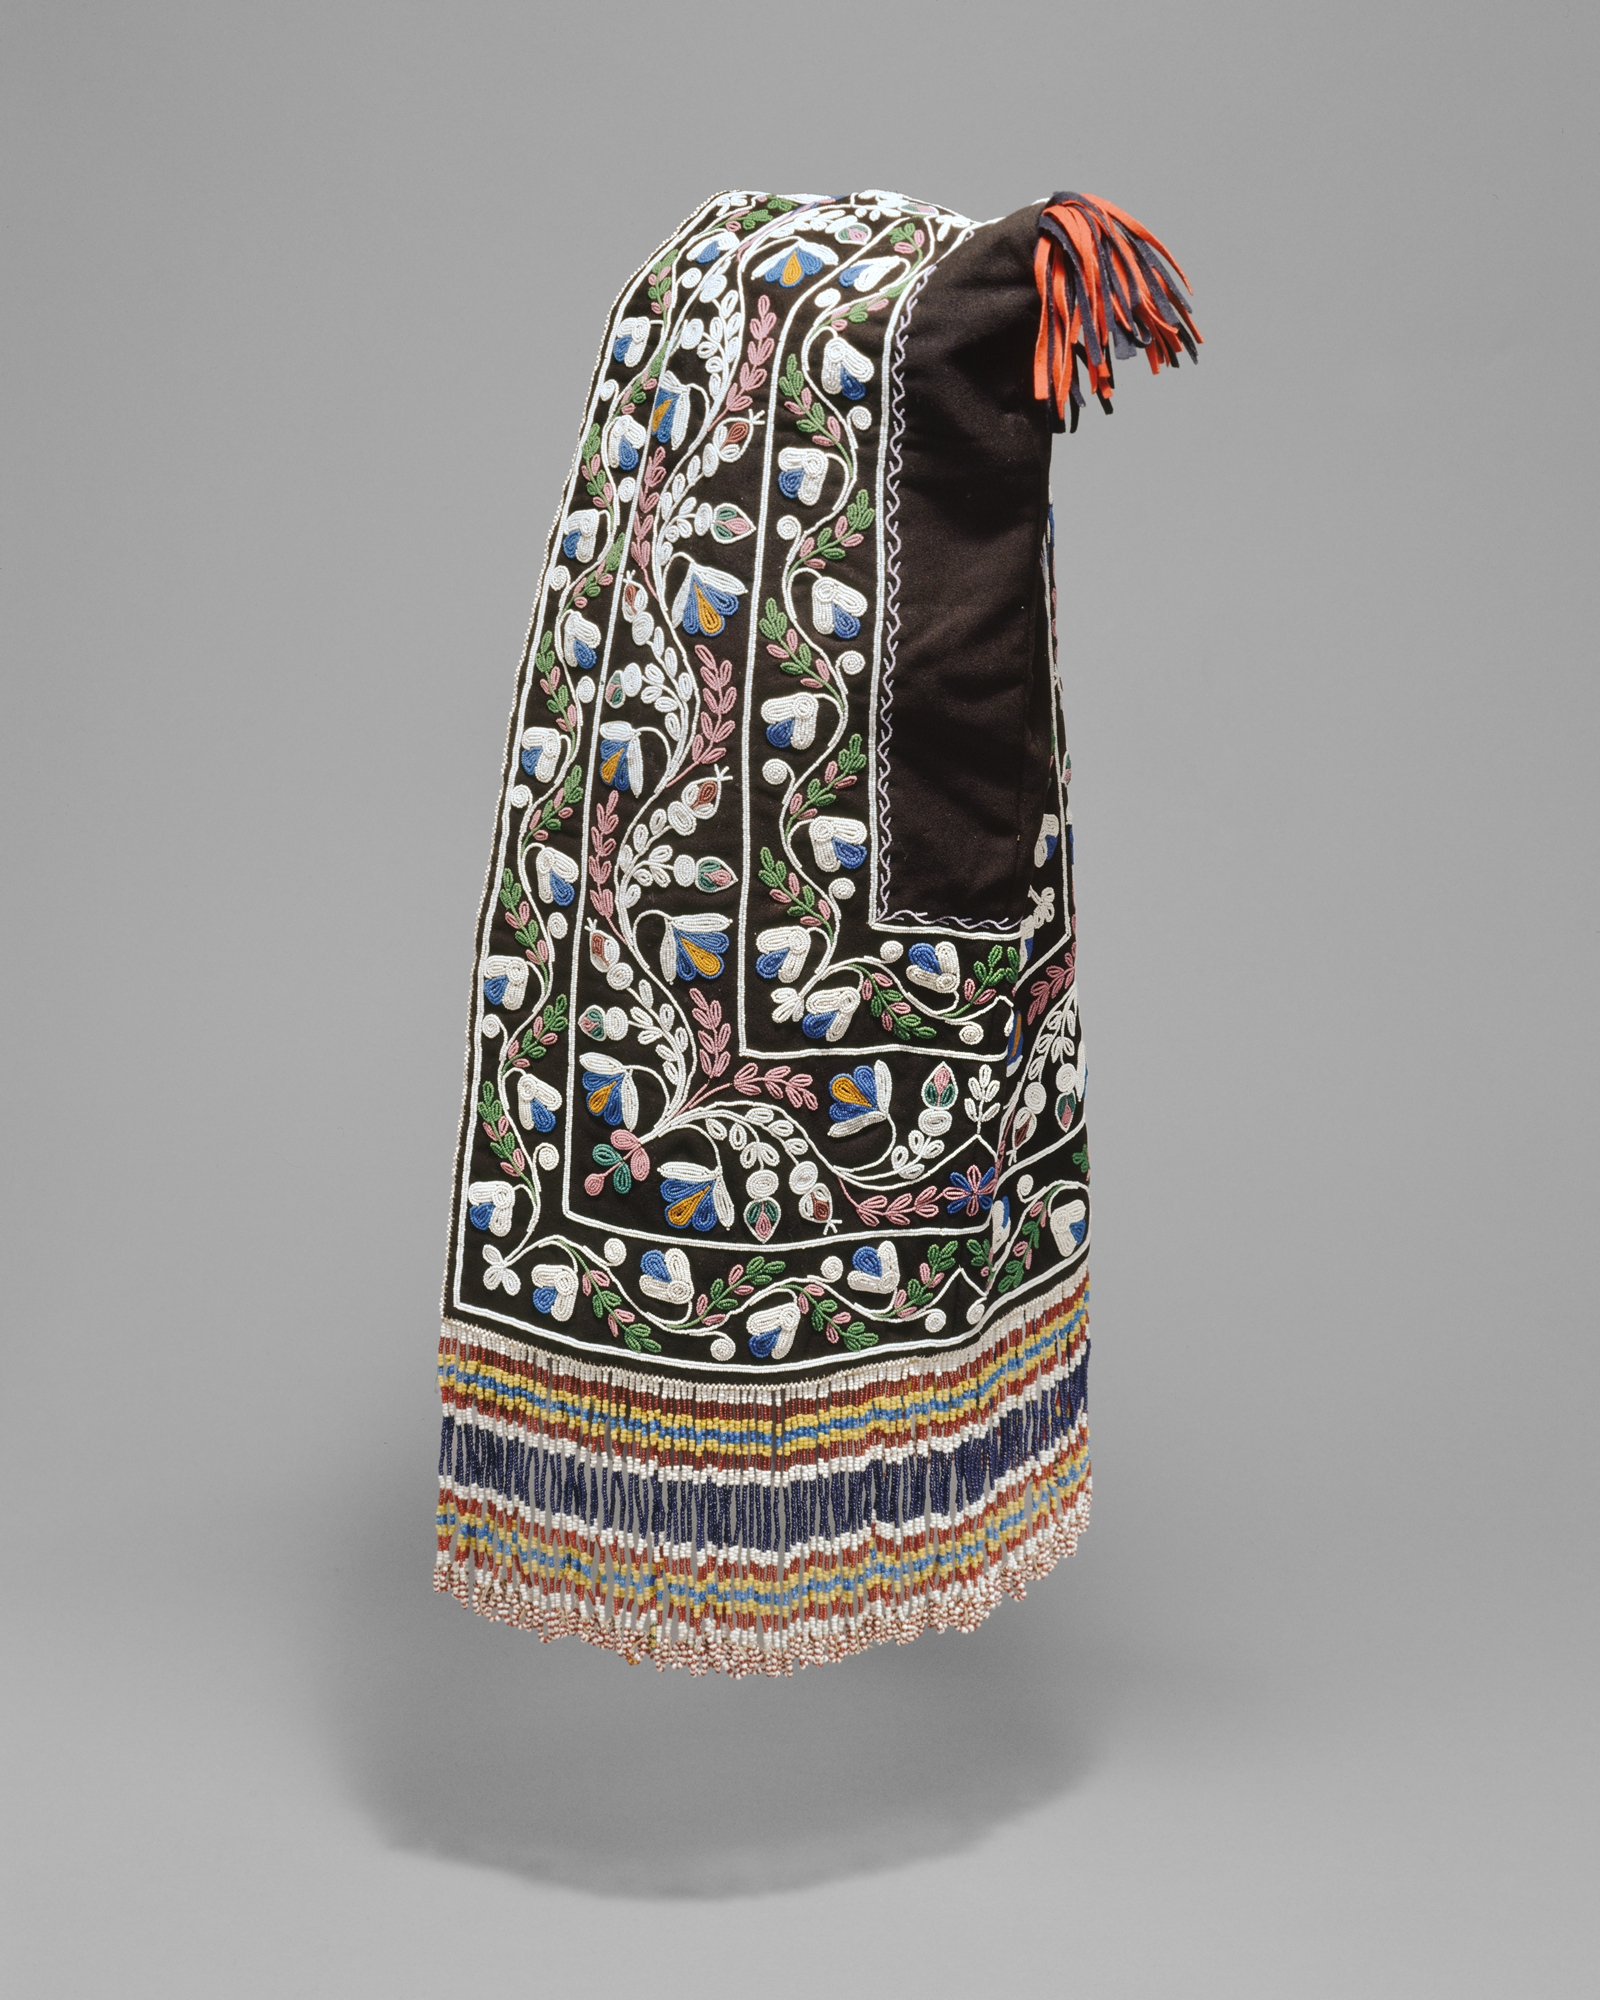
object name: hood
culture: james bay cree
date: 1840-1850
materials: cotton, glass, wool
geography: canada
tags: flowers,leaves